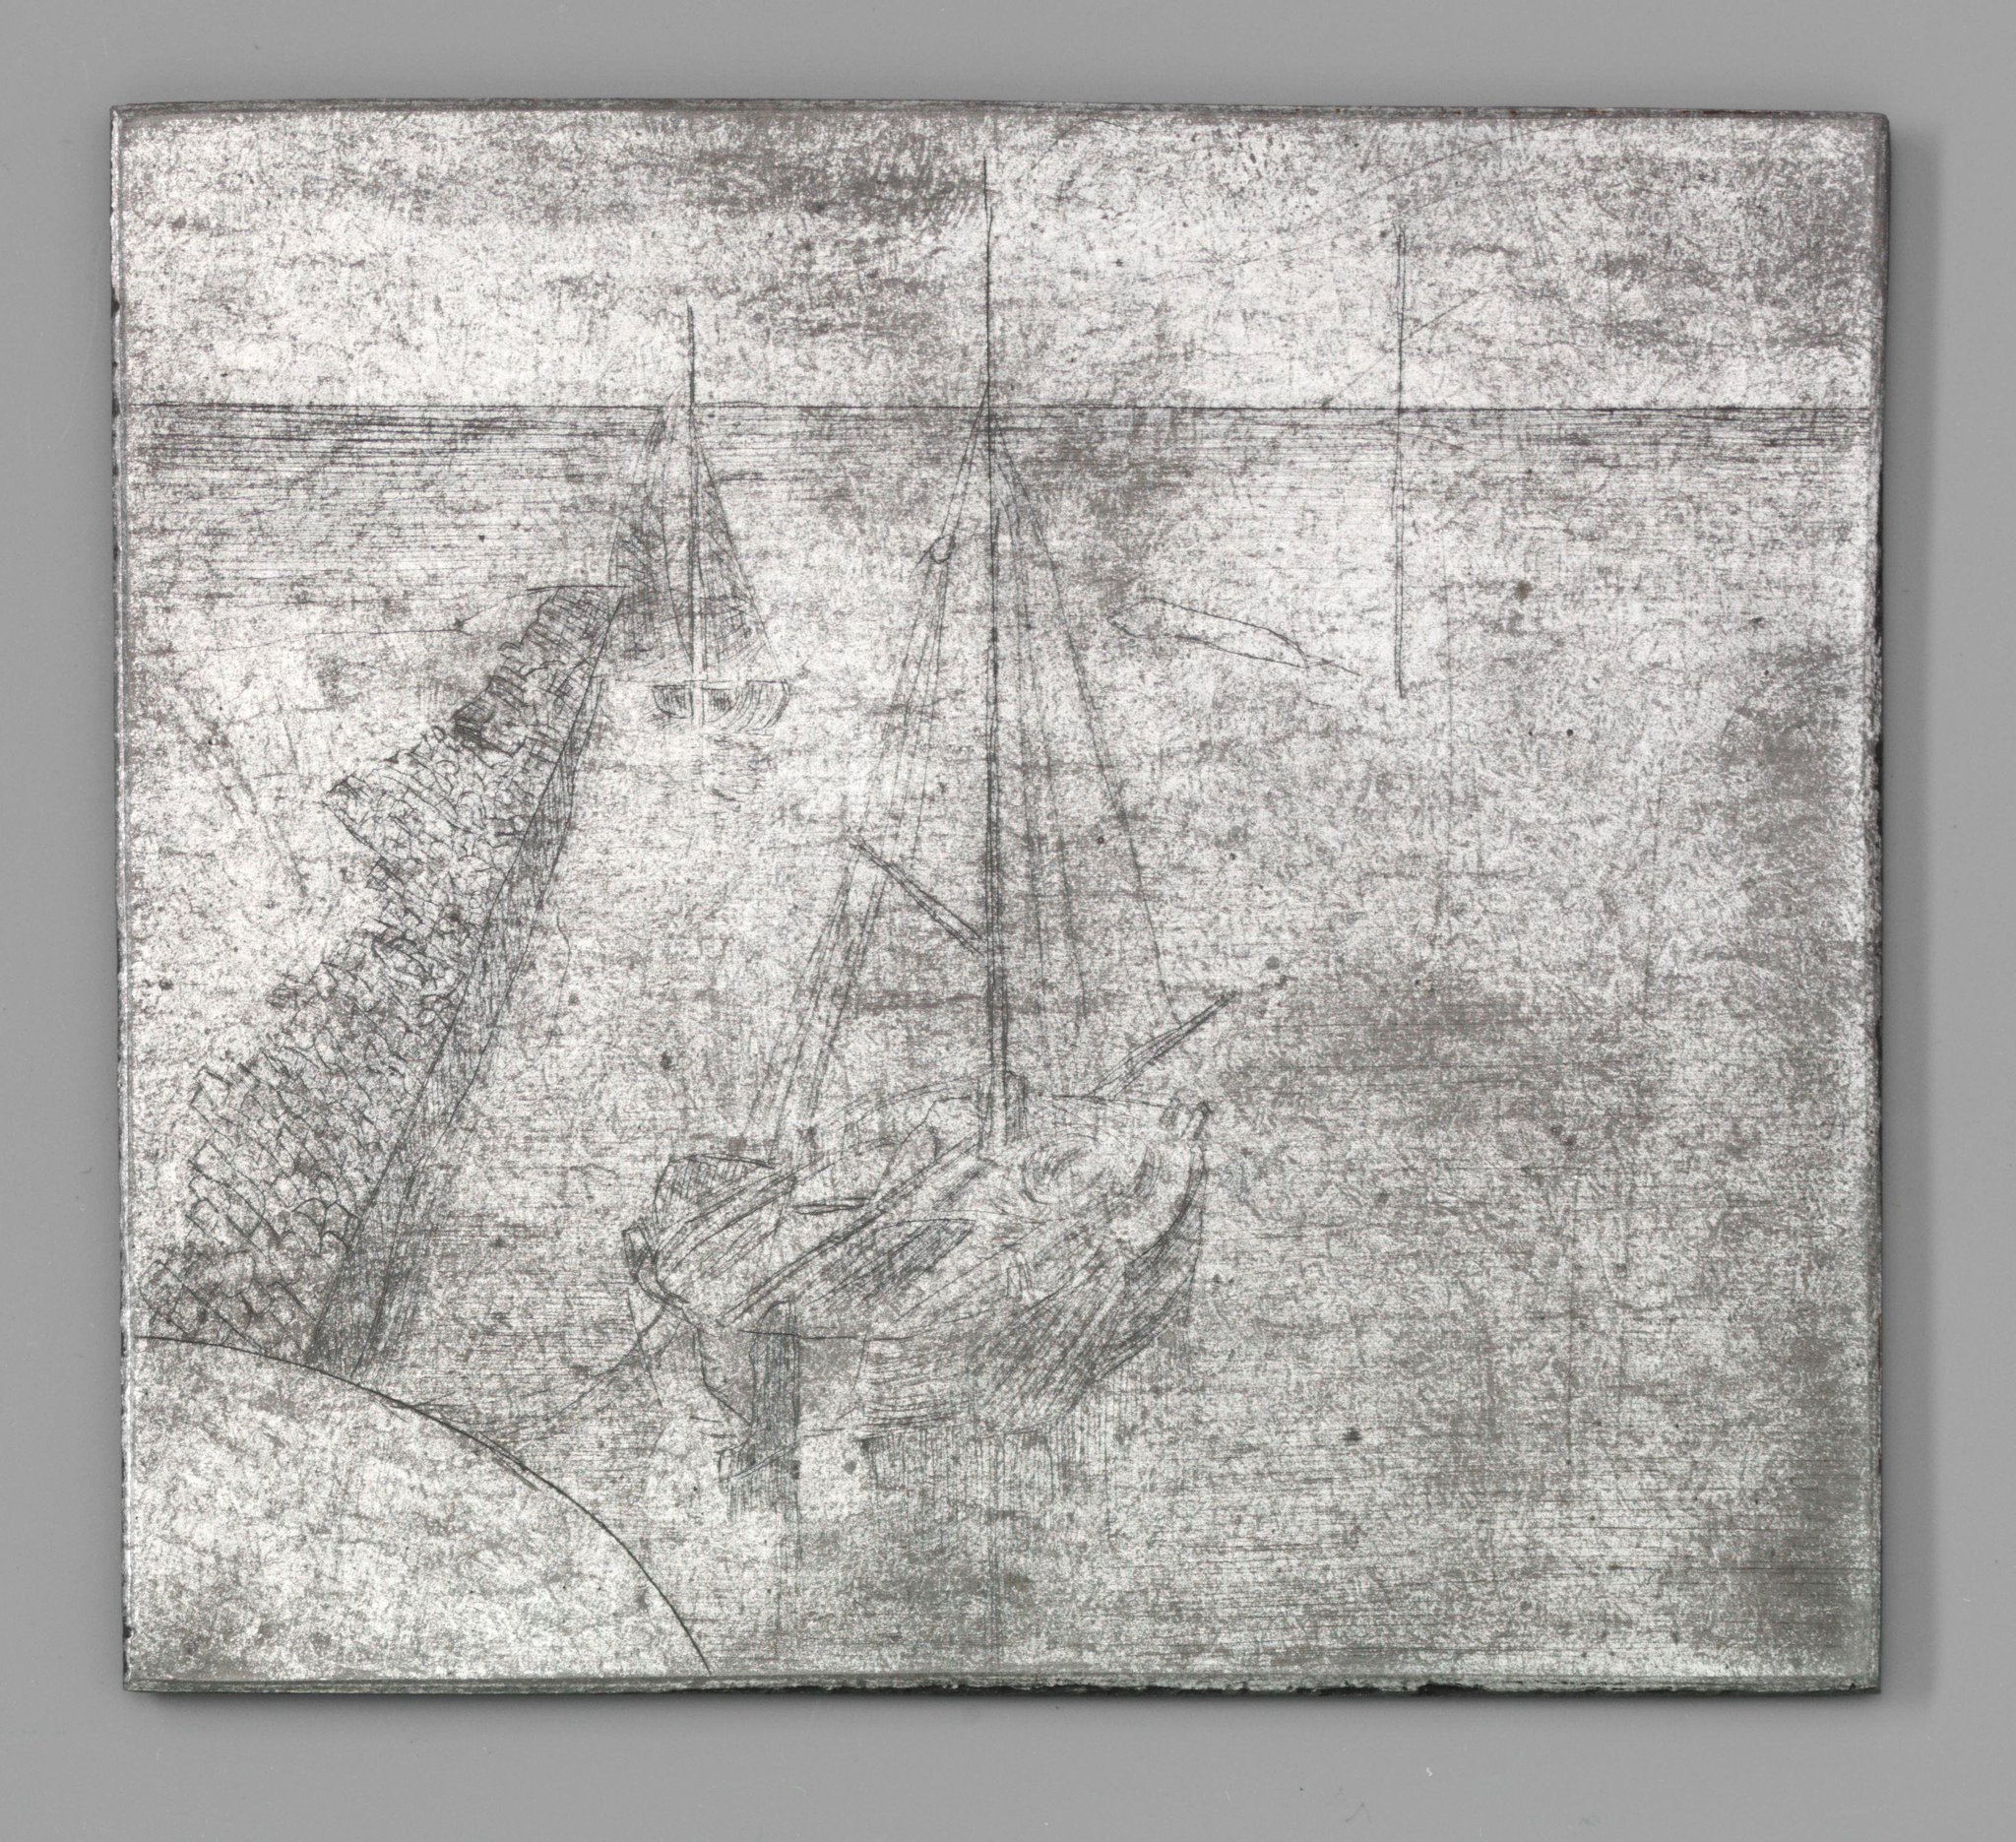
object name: zinkplaat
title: Vissersschepen in de haven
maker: jan toorop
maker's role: draughtsman, painter, print maker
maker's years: 1858-1928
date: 1868-1928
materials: zinc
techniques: drypoint